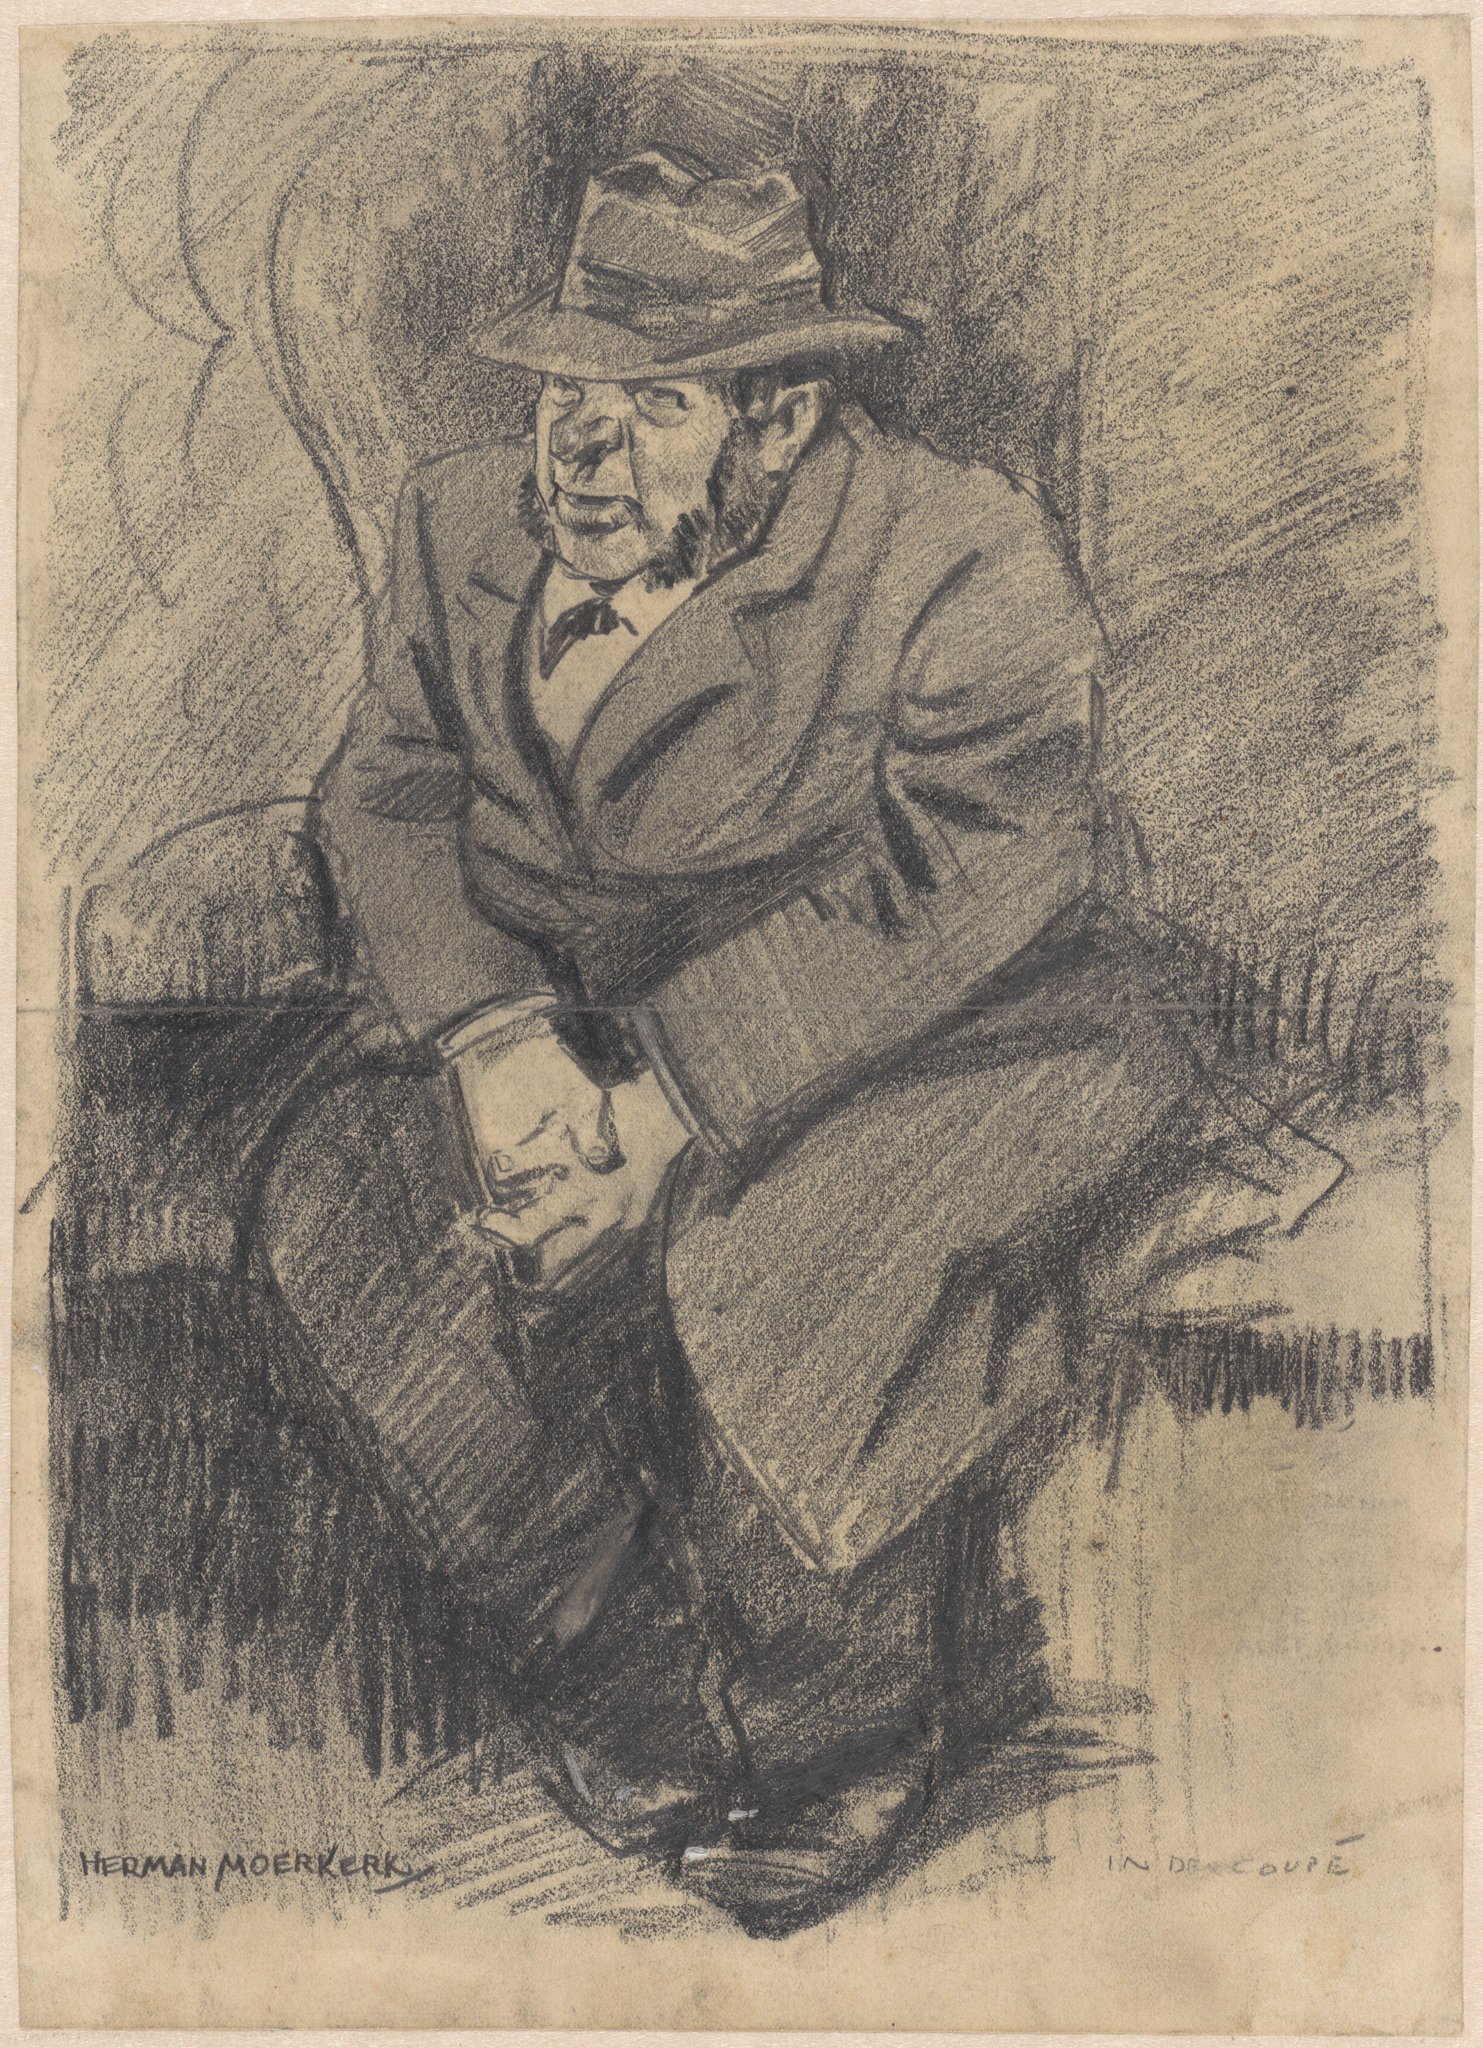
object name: drawing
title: Zittende man in de coupé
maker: herman moerkerk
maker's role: draughtsman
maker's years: 1879-1949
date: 1889-1944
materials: paper, pencil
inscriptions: annotation: ‘In de coupé’